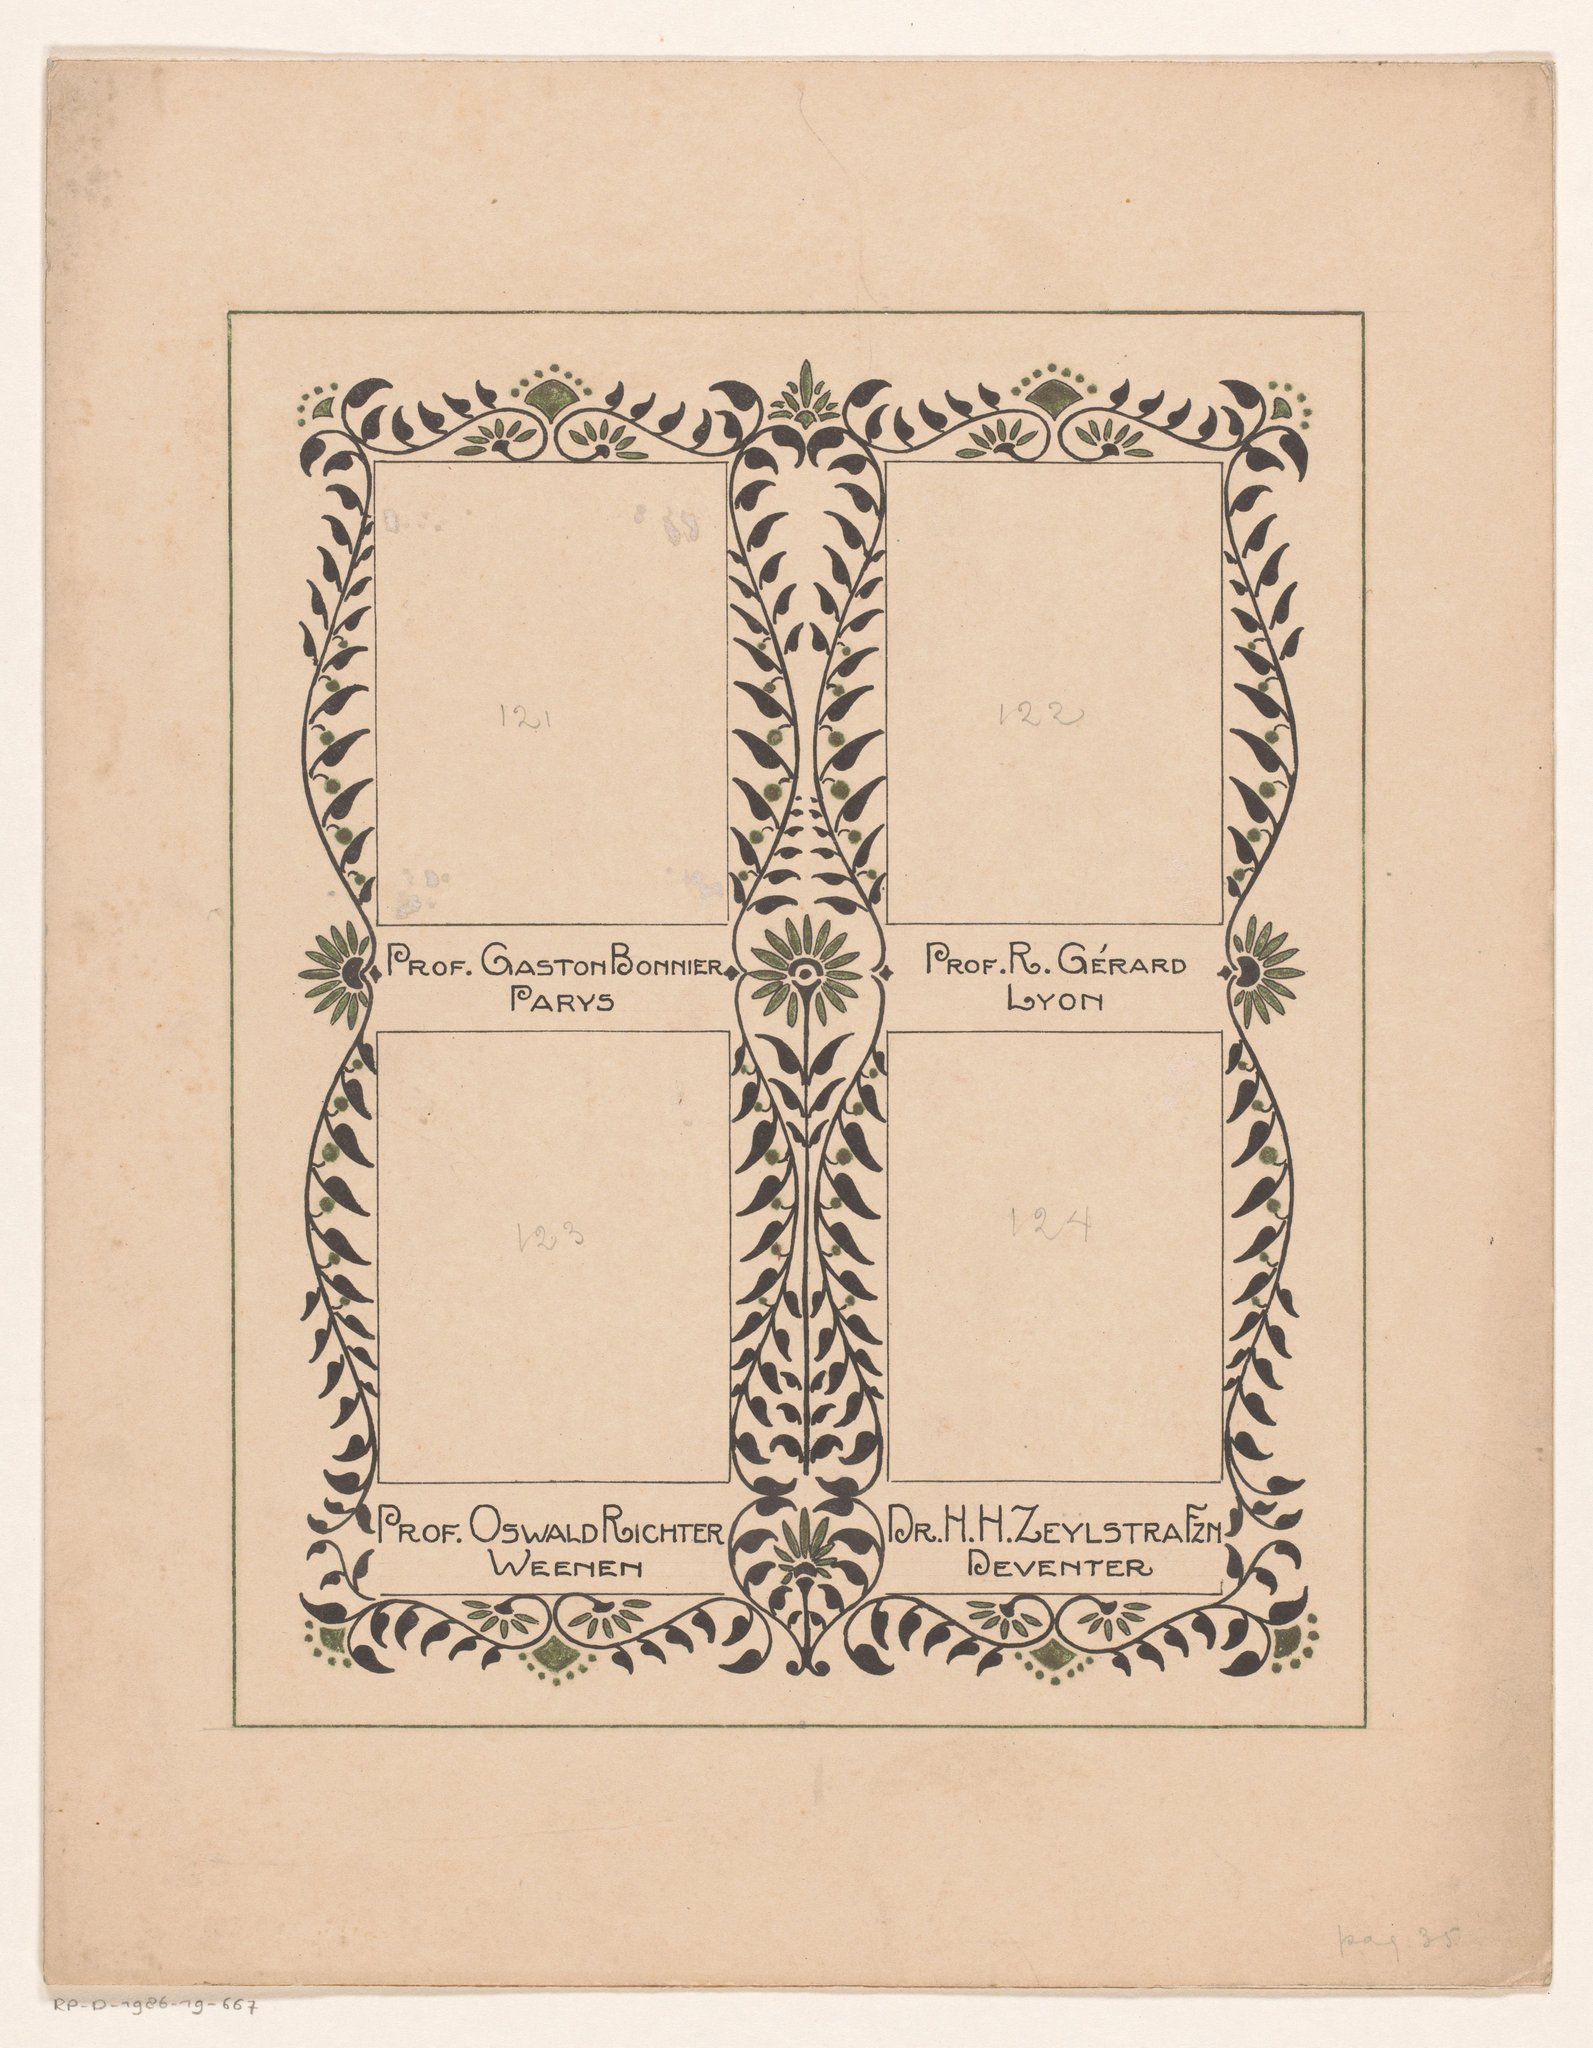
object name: photomechanical print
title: Albumblad voor een album voor Prof. Hugo de Vries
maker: reinier willem petrus de vries (1874-1953)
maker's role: draughtsman, print maker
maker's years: 1874-1953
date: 1918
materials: paint, ink, paper, pencil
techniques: brush, pen, printing block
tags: haarlem, hugo de vries, flowers ~ ornament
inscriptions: annotation: ‘pag 35.’, collector's mark: ‘R:MVS.’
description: Rechthoekig kader met bloem- en bladornamenten met daarin vier vakken voor portretten met onder elk vak de naam van de geportretteerde.